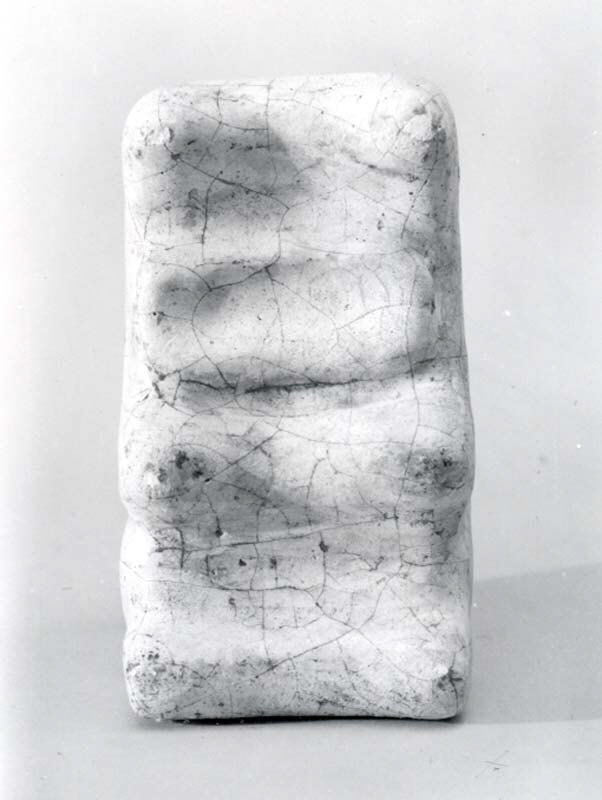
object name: object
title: Ritual object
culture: assyrian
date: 800-701 BCE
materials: ceramic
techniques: glazing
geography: mesopotamia